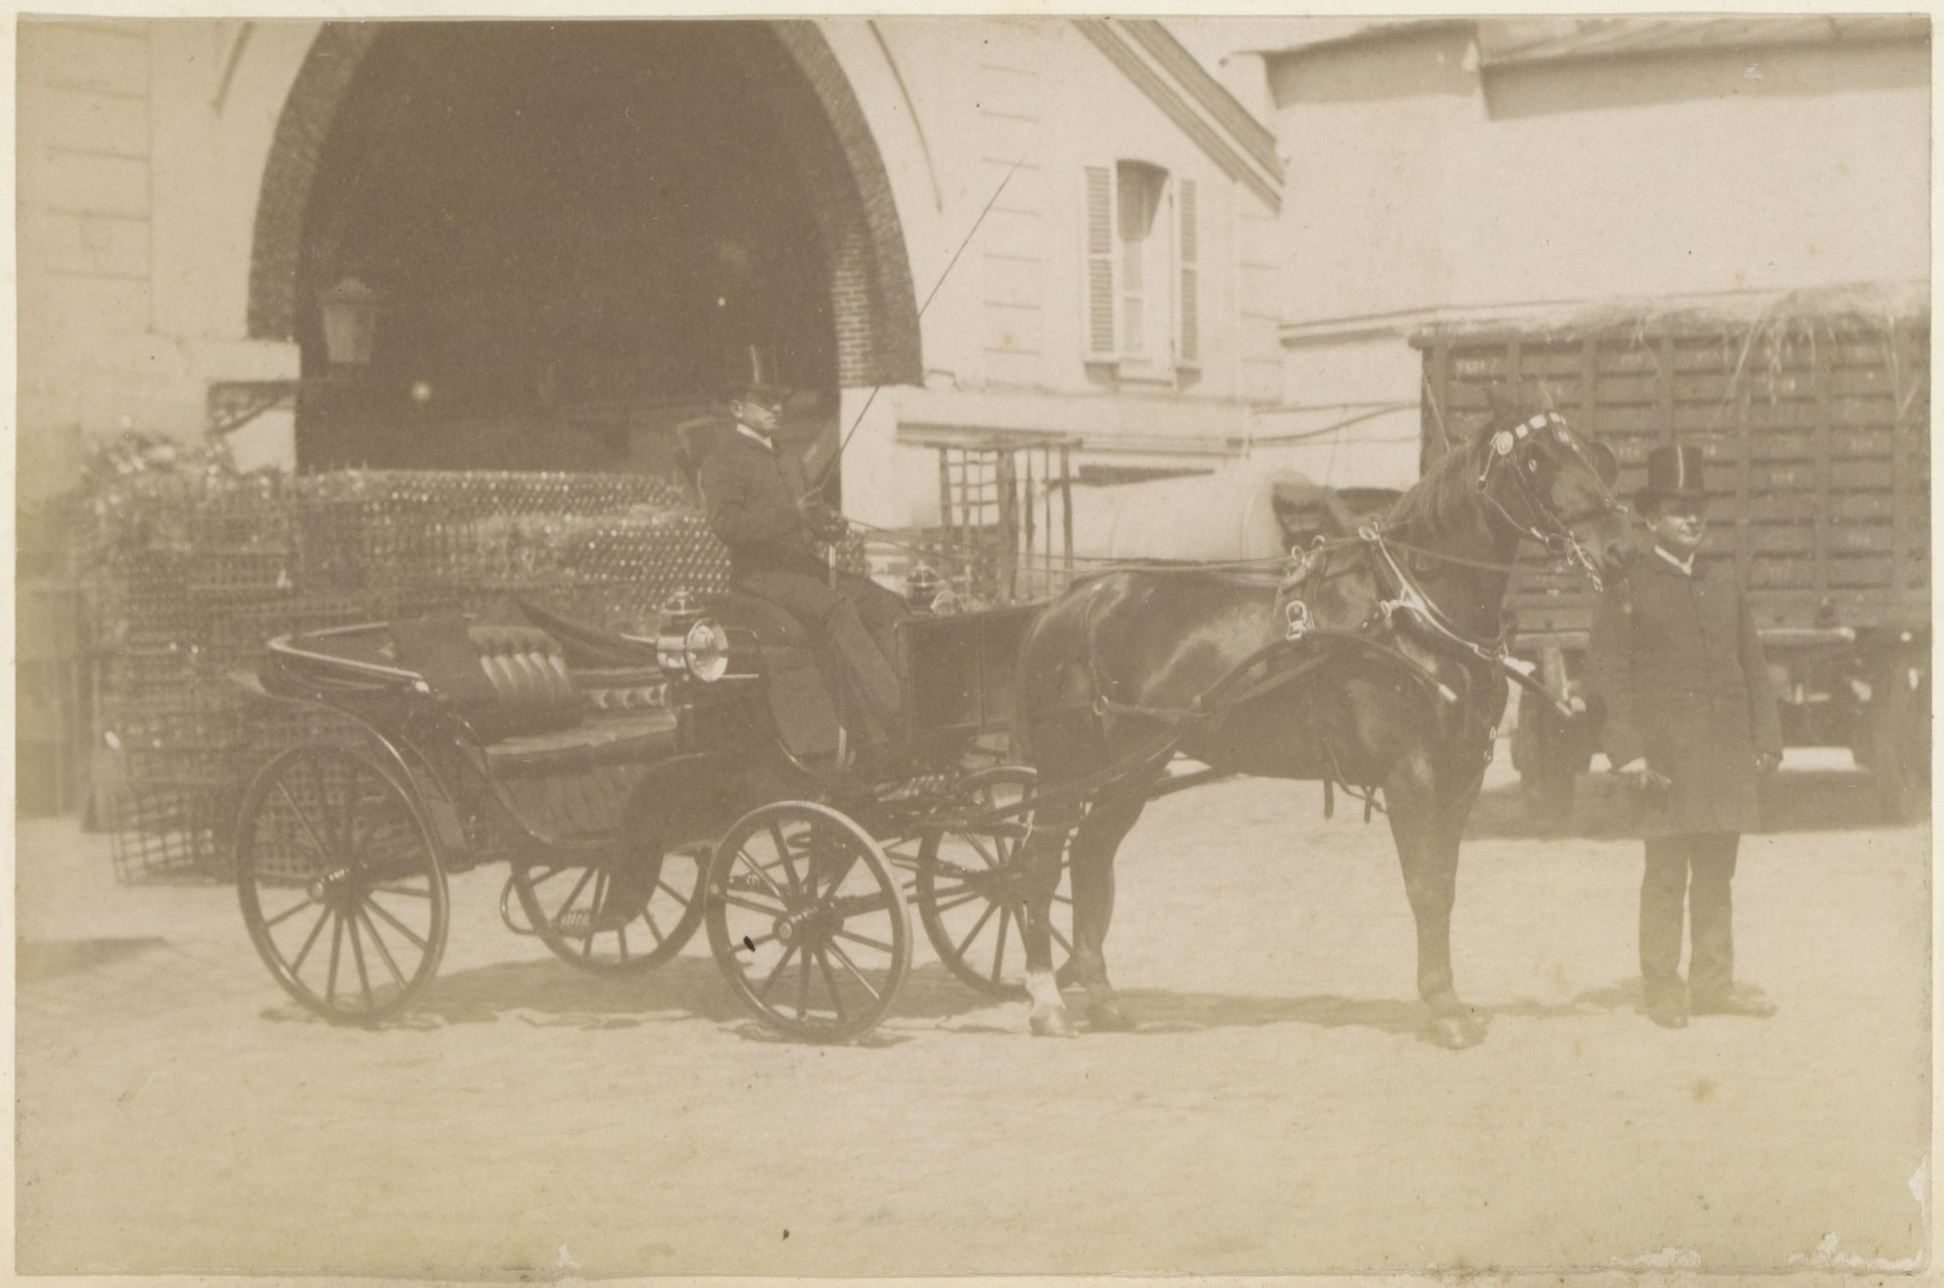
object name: photograph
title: Rijtuig met koetsiers vermoedelijk op het terrein van distilleerderij Delizy & Doistau Fils in Pantin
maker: Anonymous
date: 1900-1910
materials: paper, photographic support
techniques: albumen print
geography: pantin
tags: factory-building, four-wheeled, animal-drawn vehicle, e.g.: cab, carriage, coach, alcoholic drinks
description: Onderdeel van Fotoalbum van een Franse amateurfotograaf met opnames van een familie, distilleerderij Delizy & Doistau Fils, het leger en bezienswaardigheden in Frankrijk.